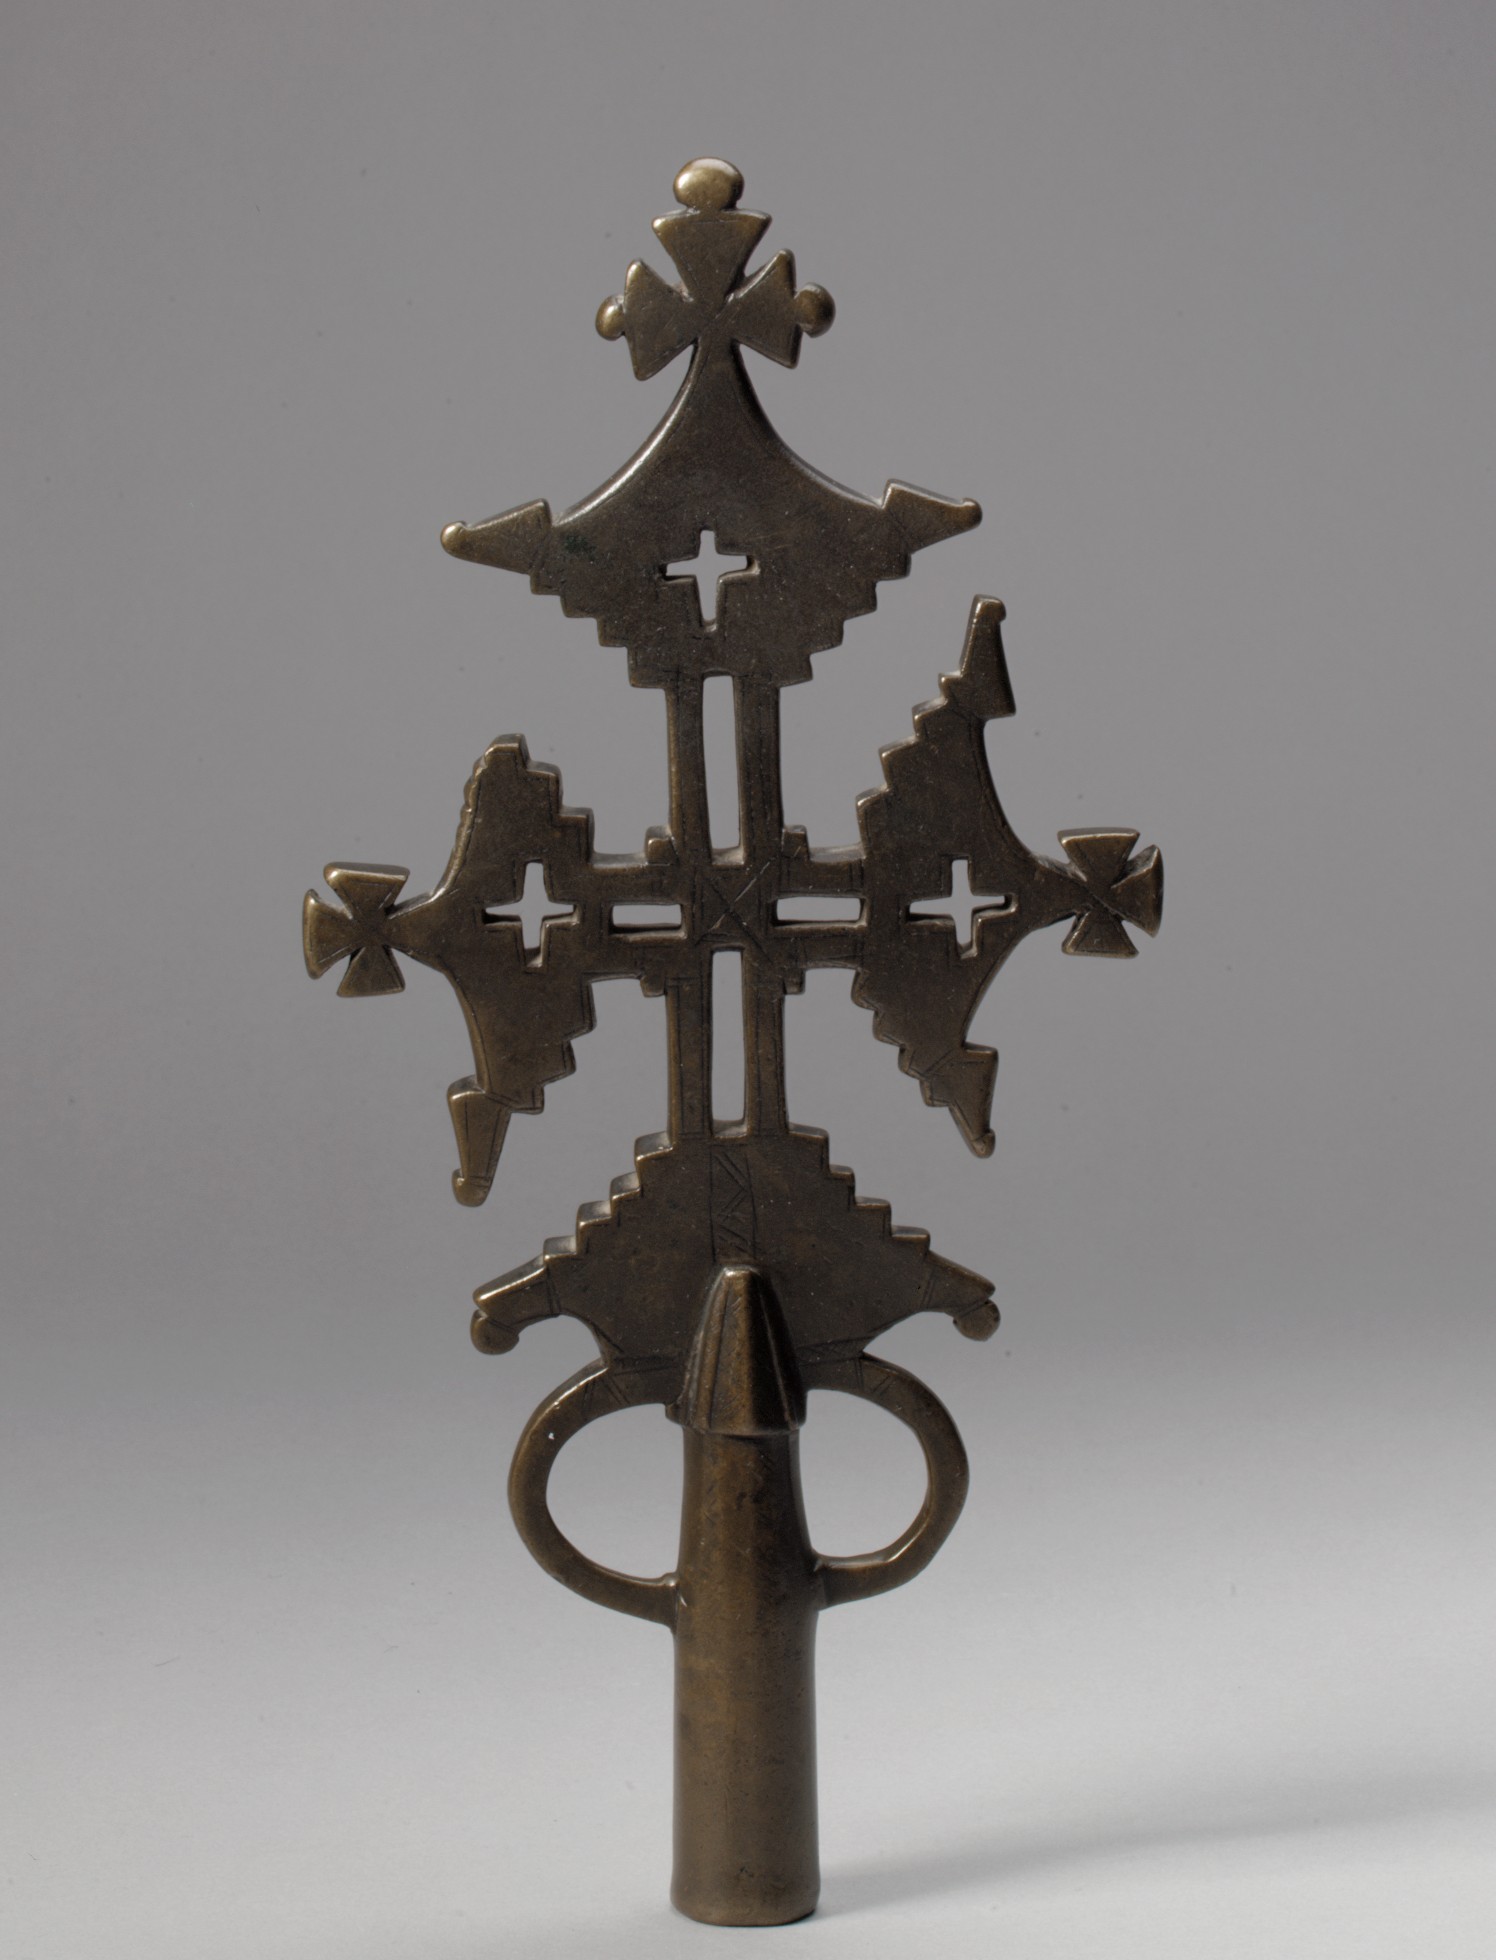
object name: cross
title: Processional Cross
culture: northern highlands region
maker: northern highlands artist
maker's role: artist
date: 1301-1500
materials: brass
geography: ethiopia